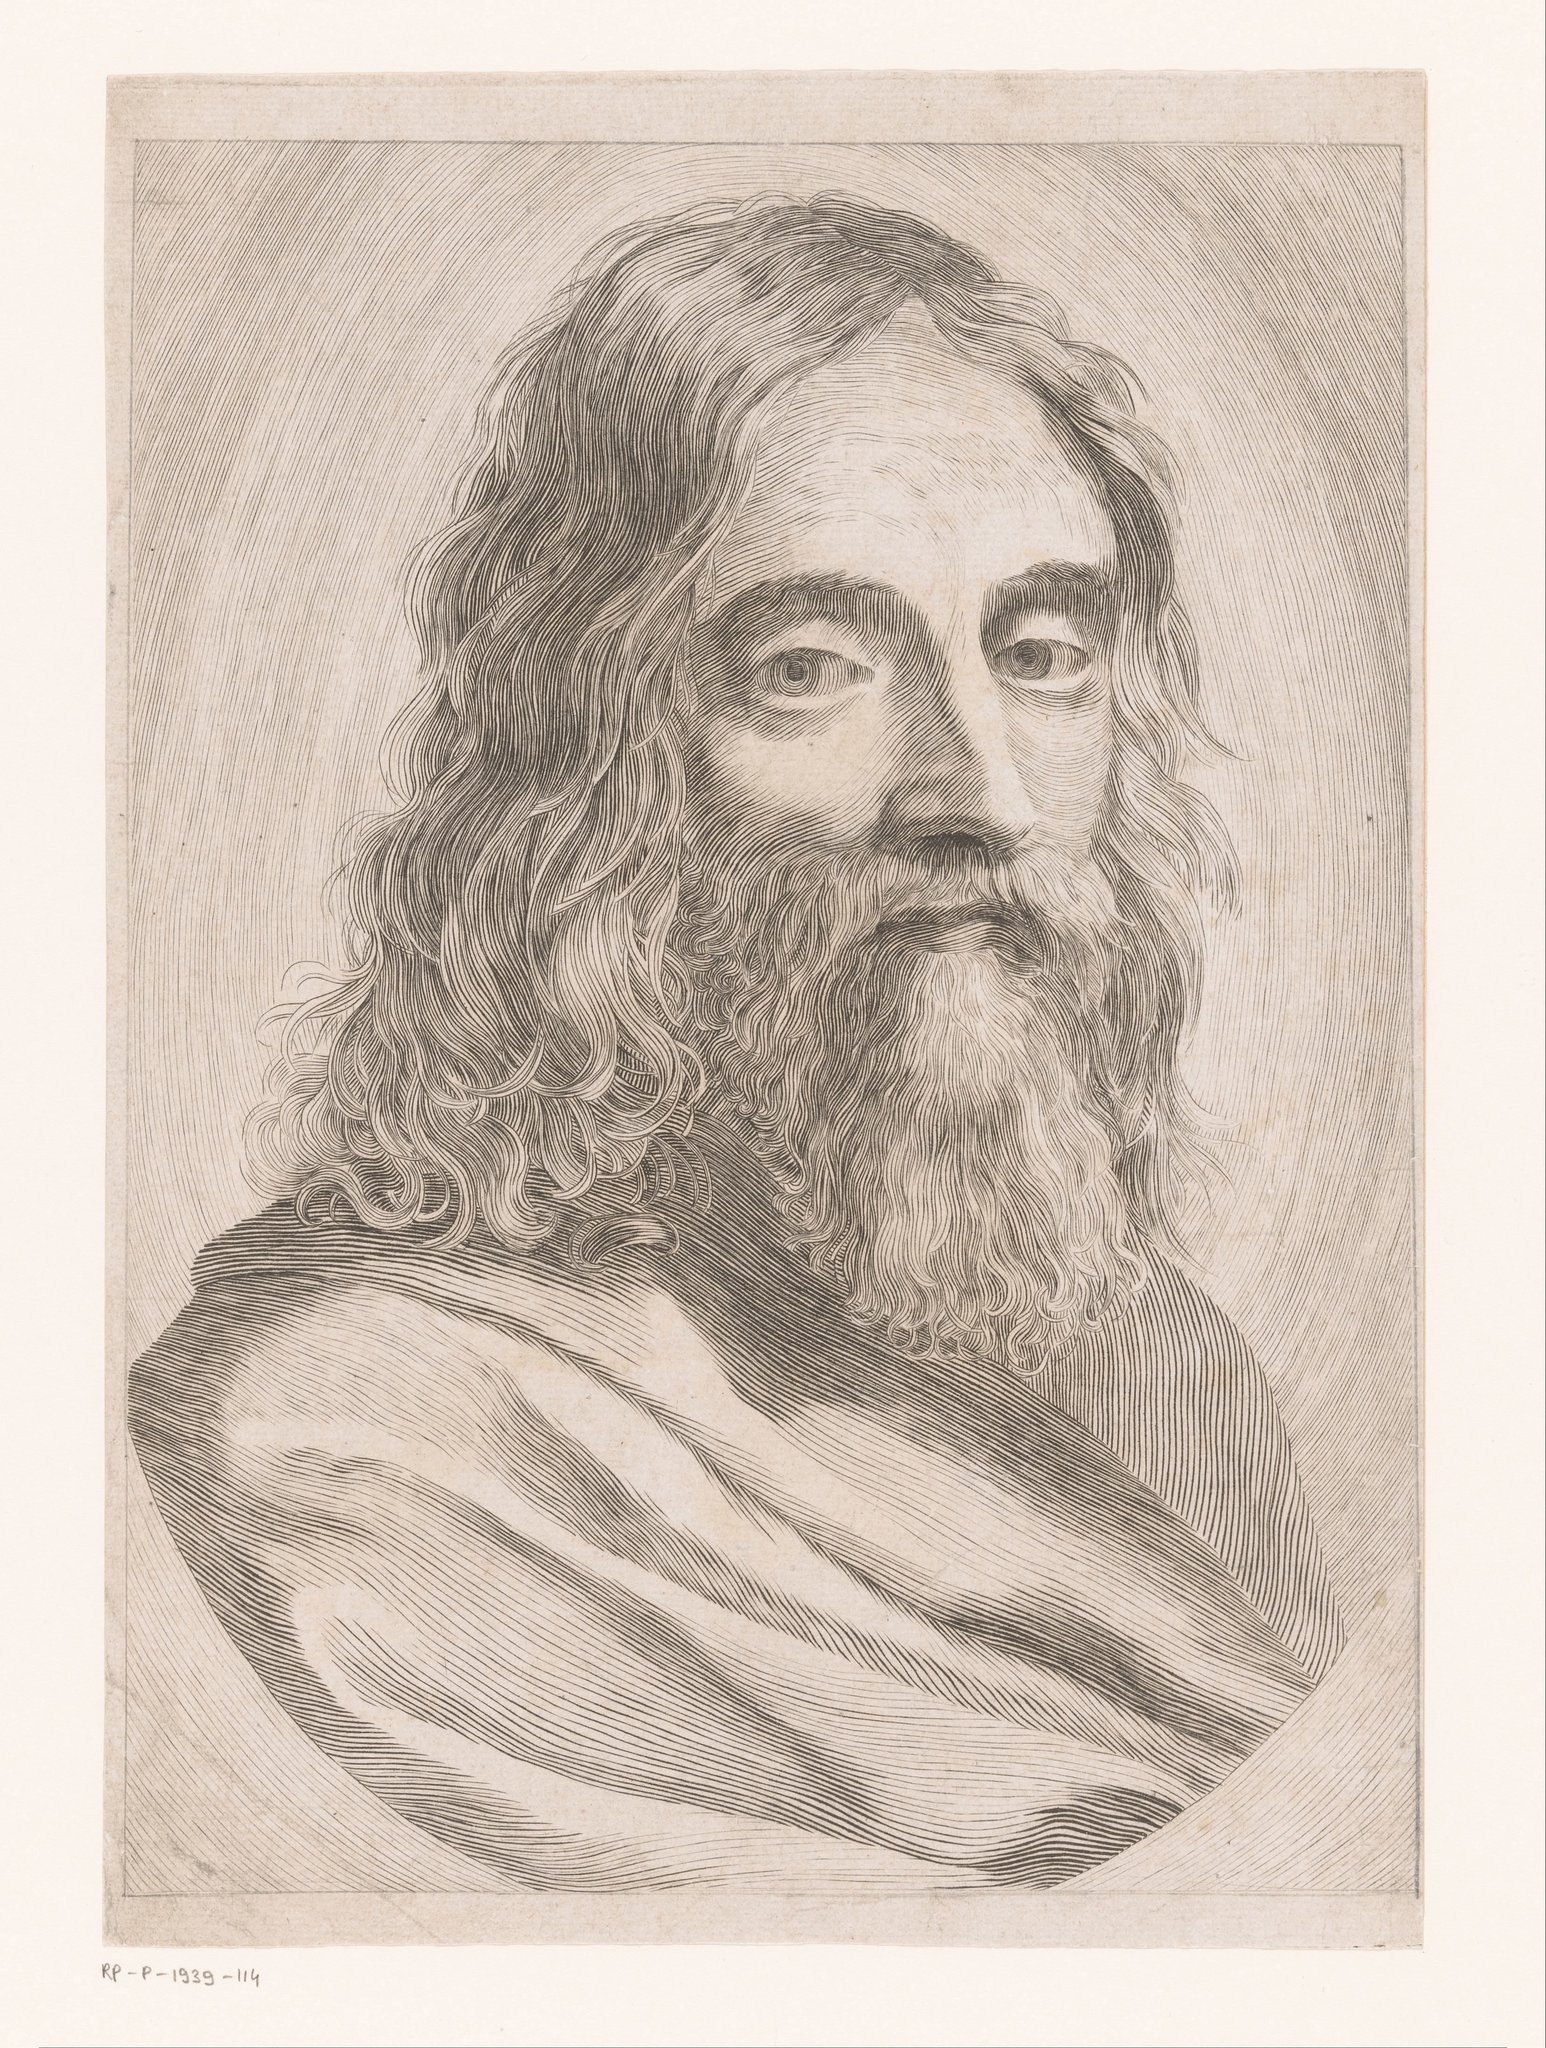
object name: print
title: H. Jozef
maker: Anonymous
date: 1643-1699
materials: paper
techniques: engraving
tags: the foster-father of christ, joseph of nazareth, husband of mary; possible attributes: flowering rod or wand, lily, carpenter's tools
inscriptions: collector's mark: Lugt 2760